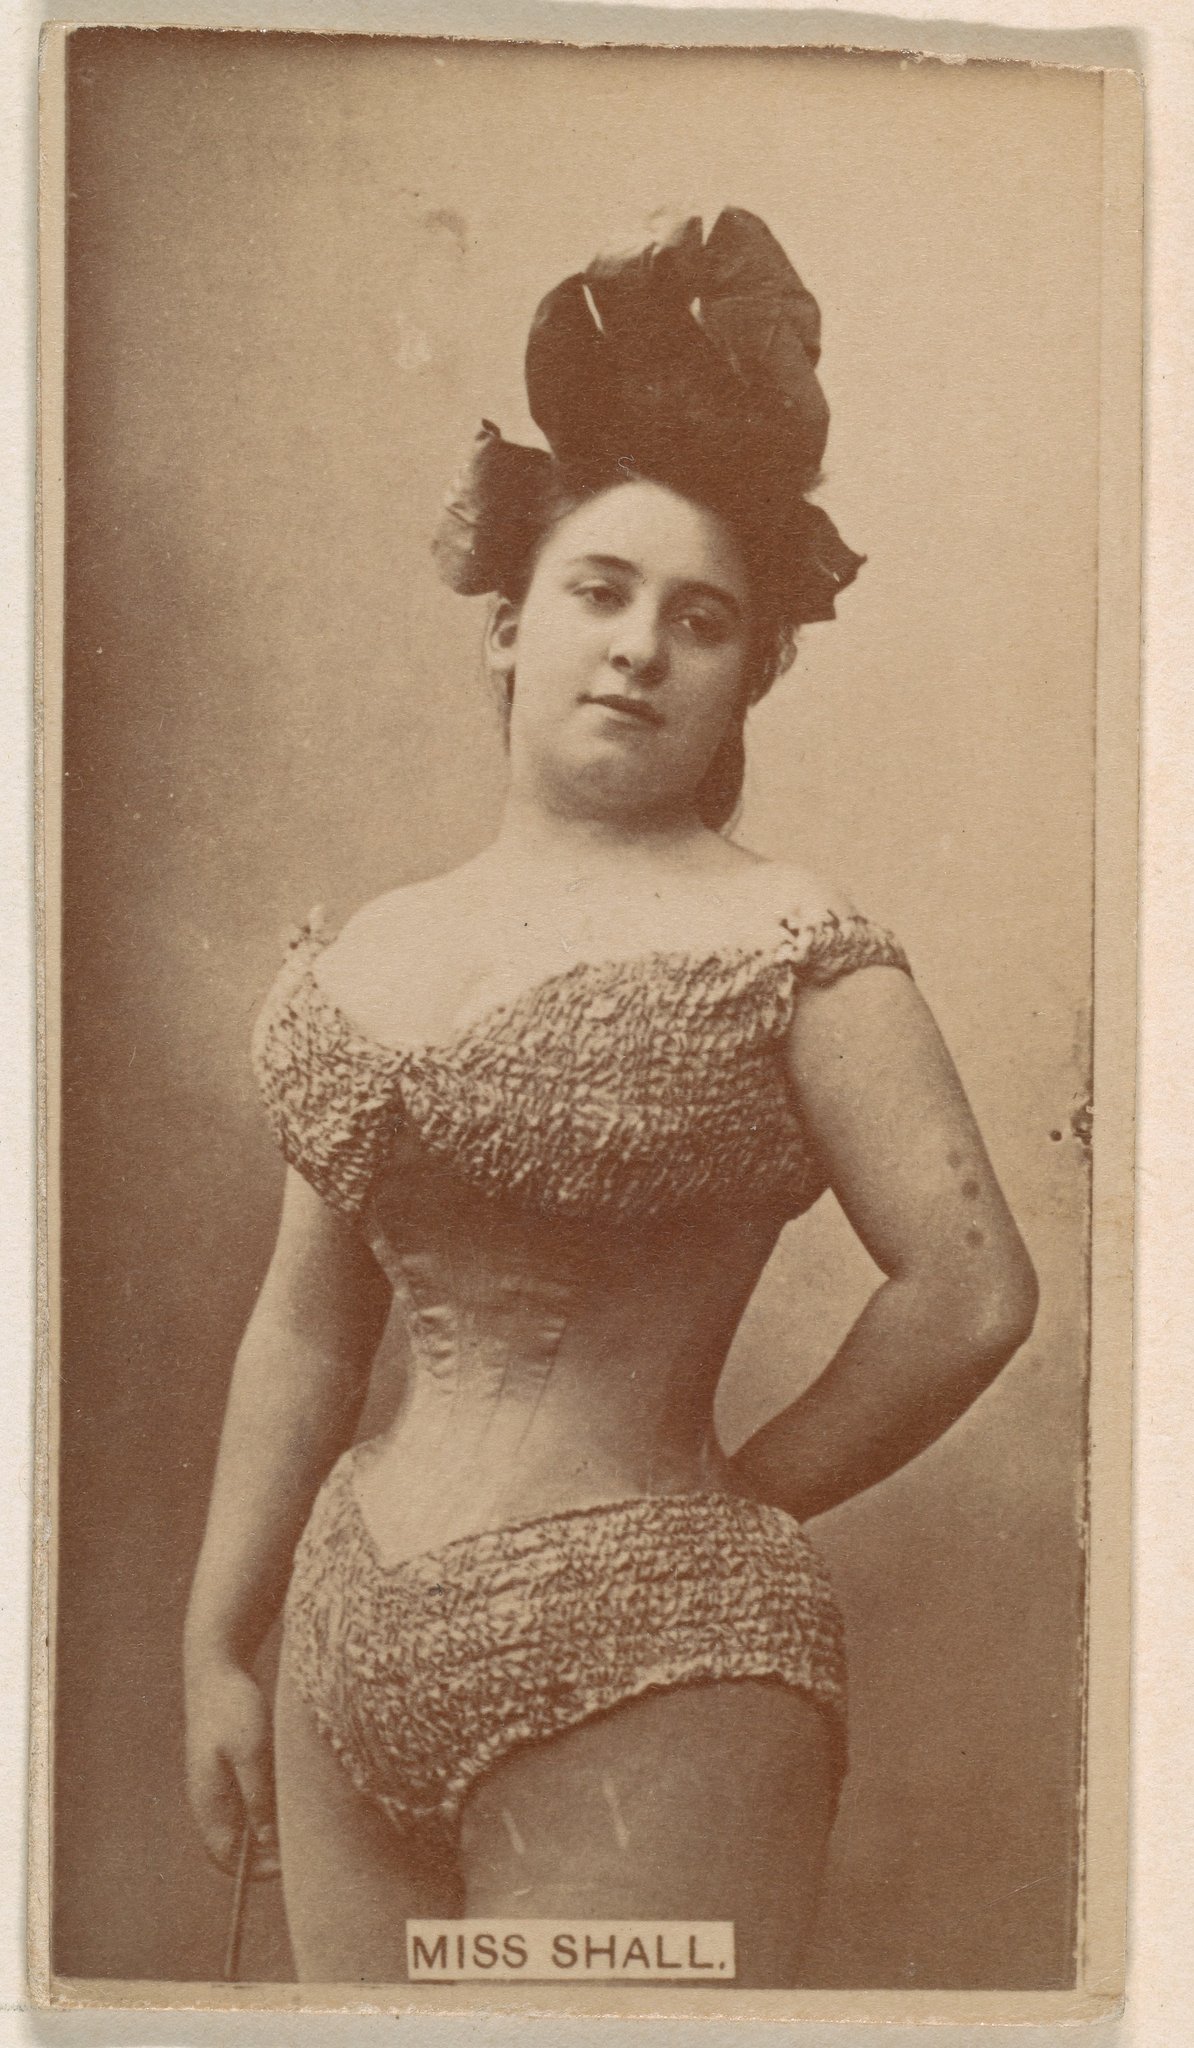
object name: photograph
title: Miss Shall, from the Actresses series (N245) issued by Kinney Brothers to promote Sweet Caporal Cigarettes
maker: kinney brothers tobacco company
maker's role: publisher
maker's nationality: american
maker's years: 1869-2011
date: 1890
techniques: albumen silver print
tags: portraits,women,actresses